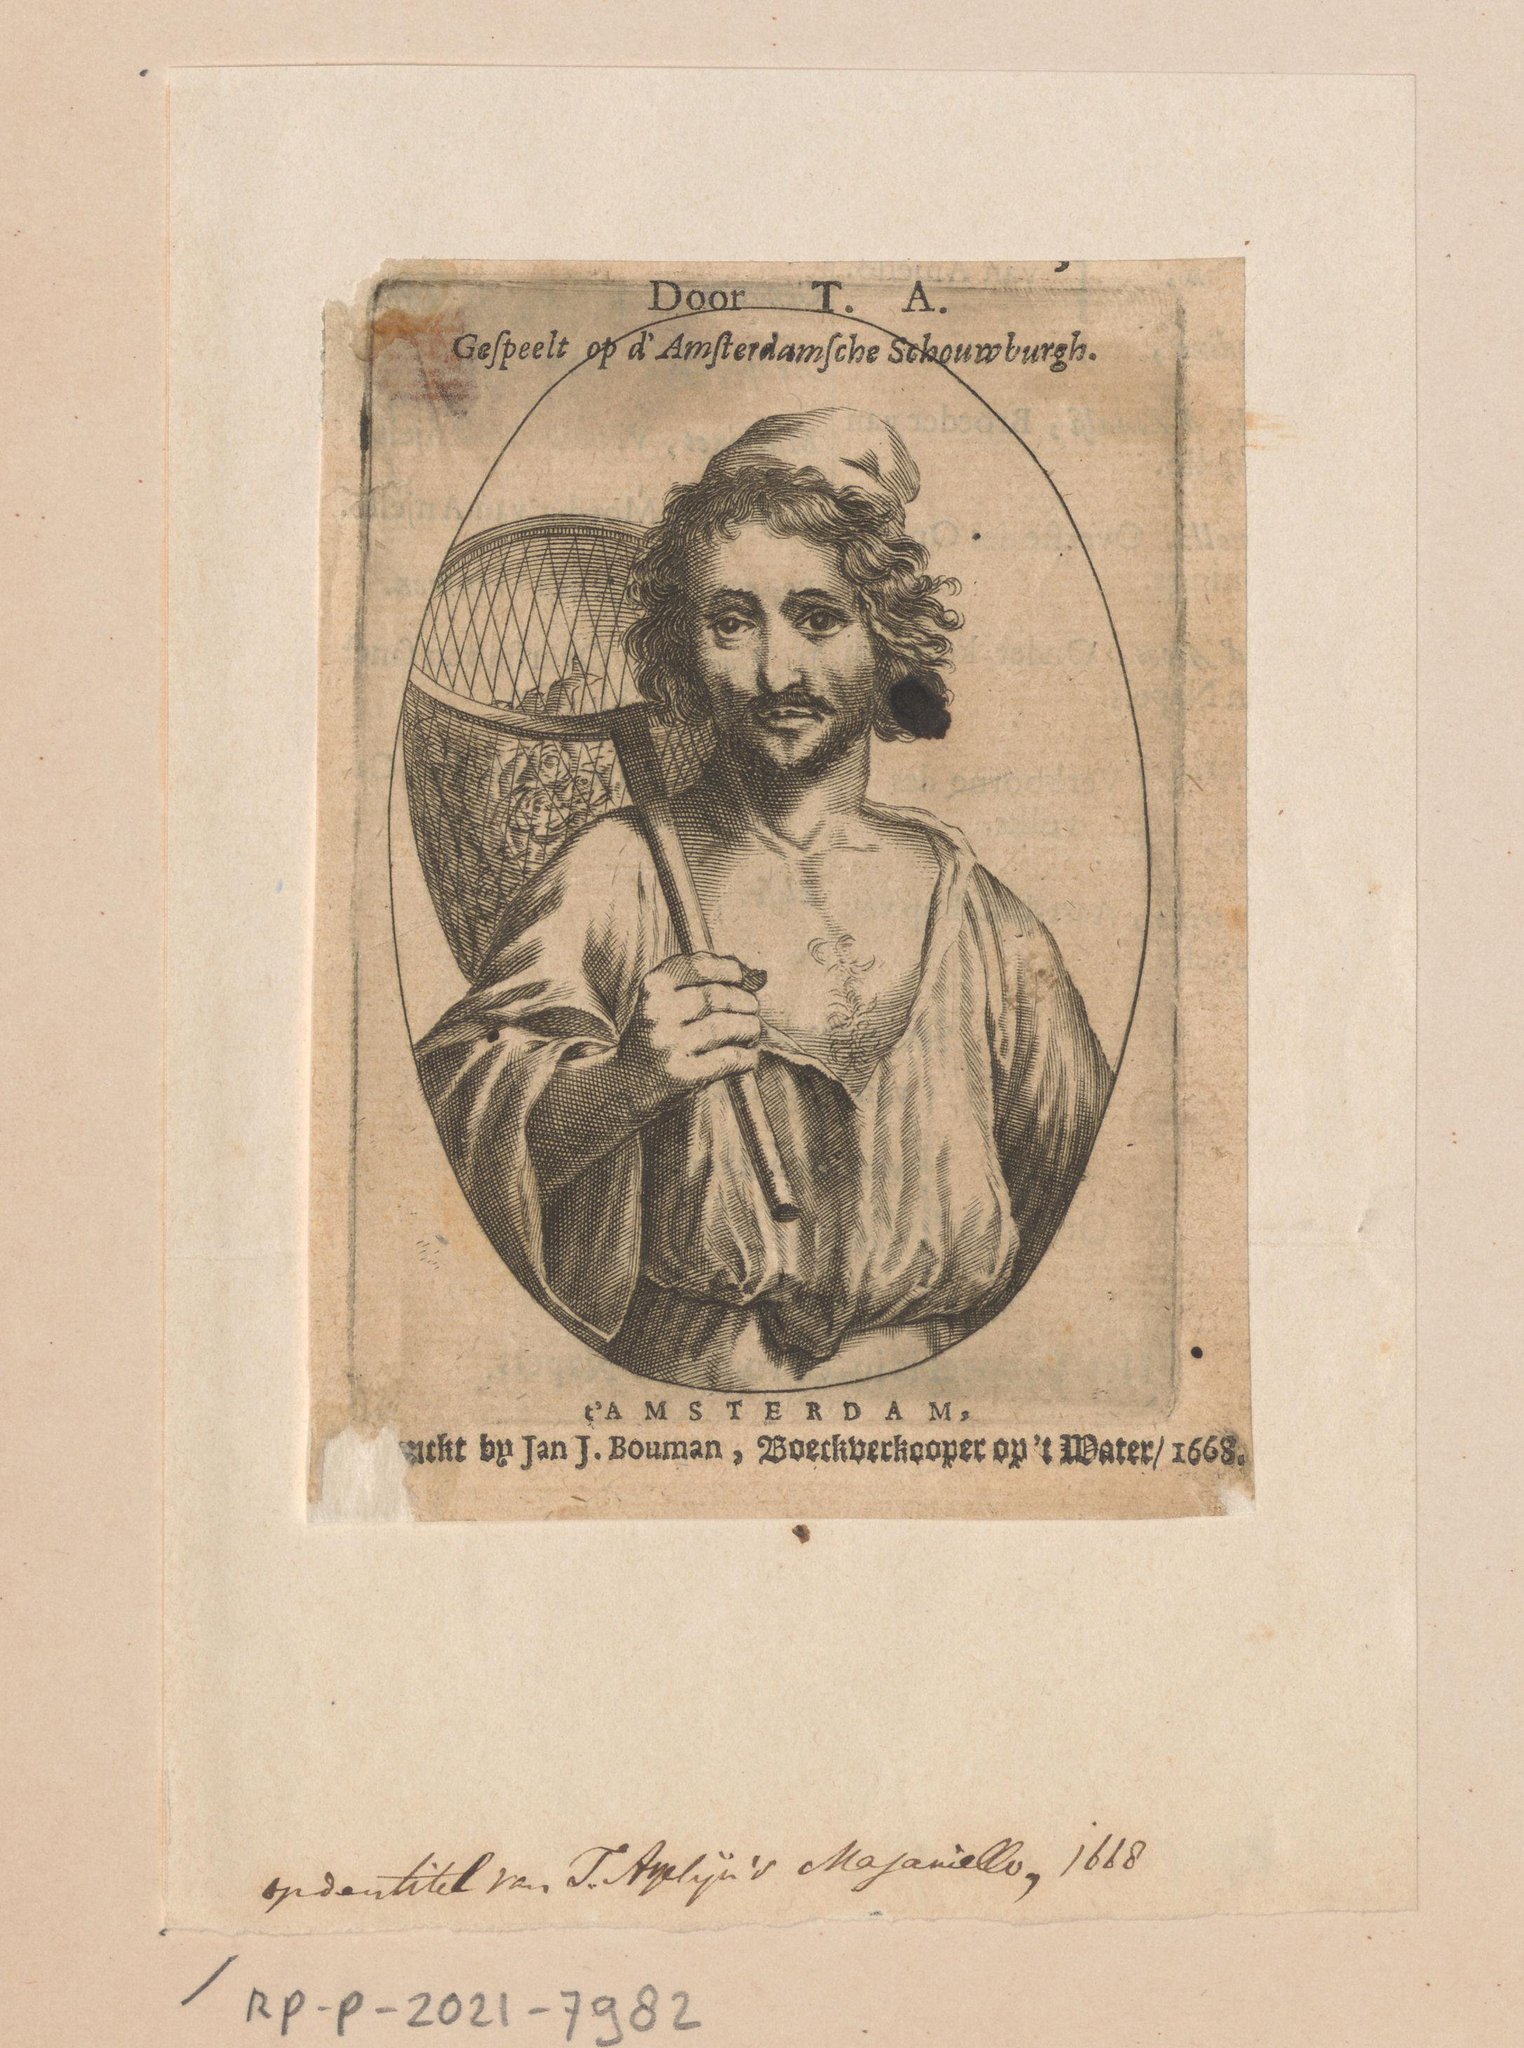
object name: titelblad, titelpagina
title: Portret van Masaniello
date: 1668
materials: paper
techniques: engraving, etching, letterpress printing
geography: amsterdam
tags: naples, historical persons, fisherman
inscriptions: inscription: ‘op den titel van T. Asselijn's Masaniello, 1668’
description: Titelpagina voor: Asselijn, Thomas. Op- en ondergang van mas Anjello, of Napelse beroerte (...). Amsterdam: Jan Jacobsz. Bouman, 1668.